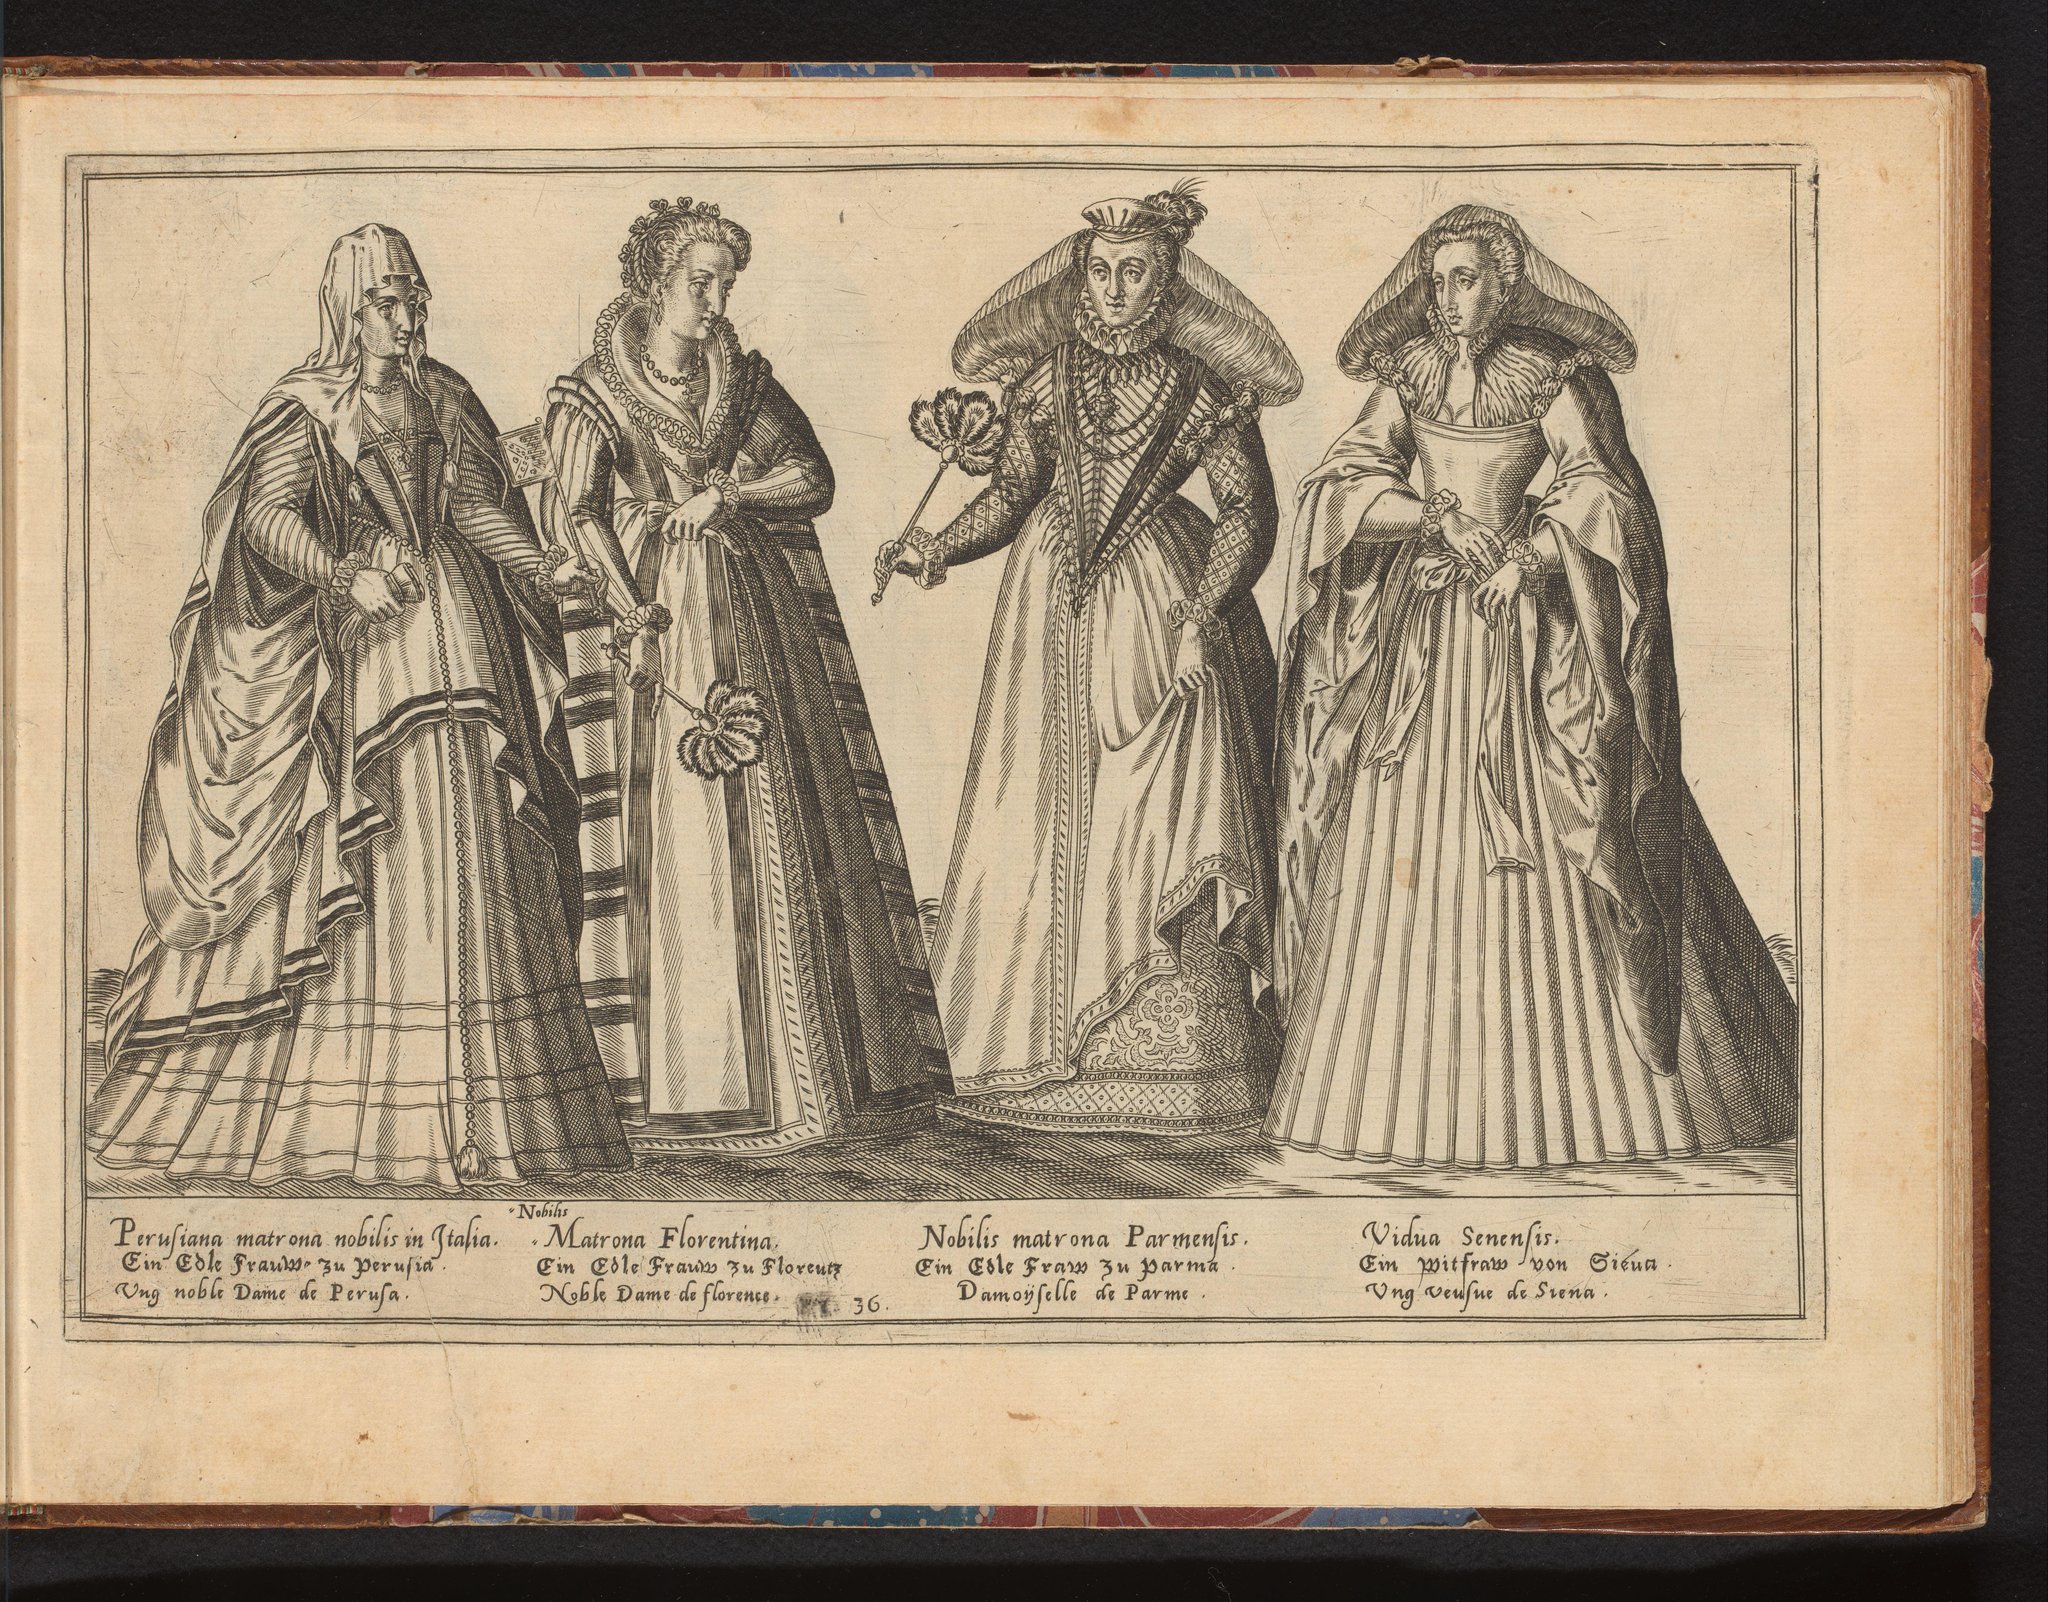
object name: album leaf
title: Vier vrouwen, gekleed volgens de Italiaanse mode van ca. 1580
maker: abraham de bruyn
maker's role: print maker, publisher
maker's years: 1540-1587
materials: paper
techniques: engraving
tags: europeans (italians) (+ women), fan, europeans (with name) (+ costume), veil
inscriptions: number: ‘36’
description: Prent uit het boek 'Omnium pene Europae, Asiae, Aphricae atque Americae gentium habitus...', 1581. De prent maakt deel uit van een album.